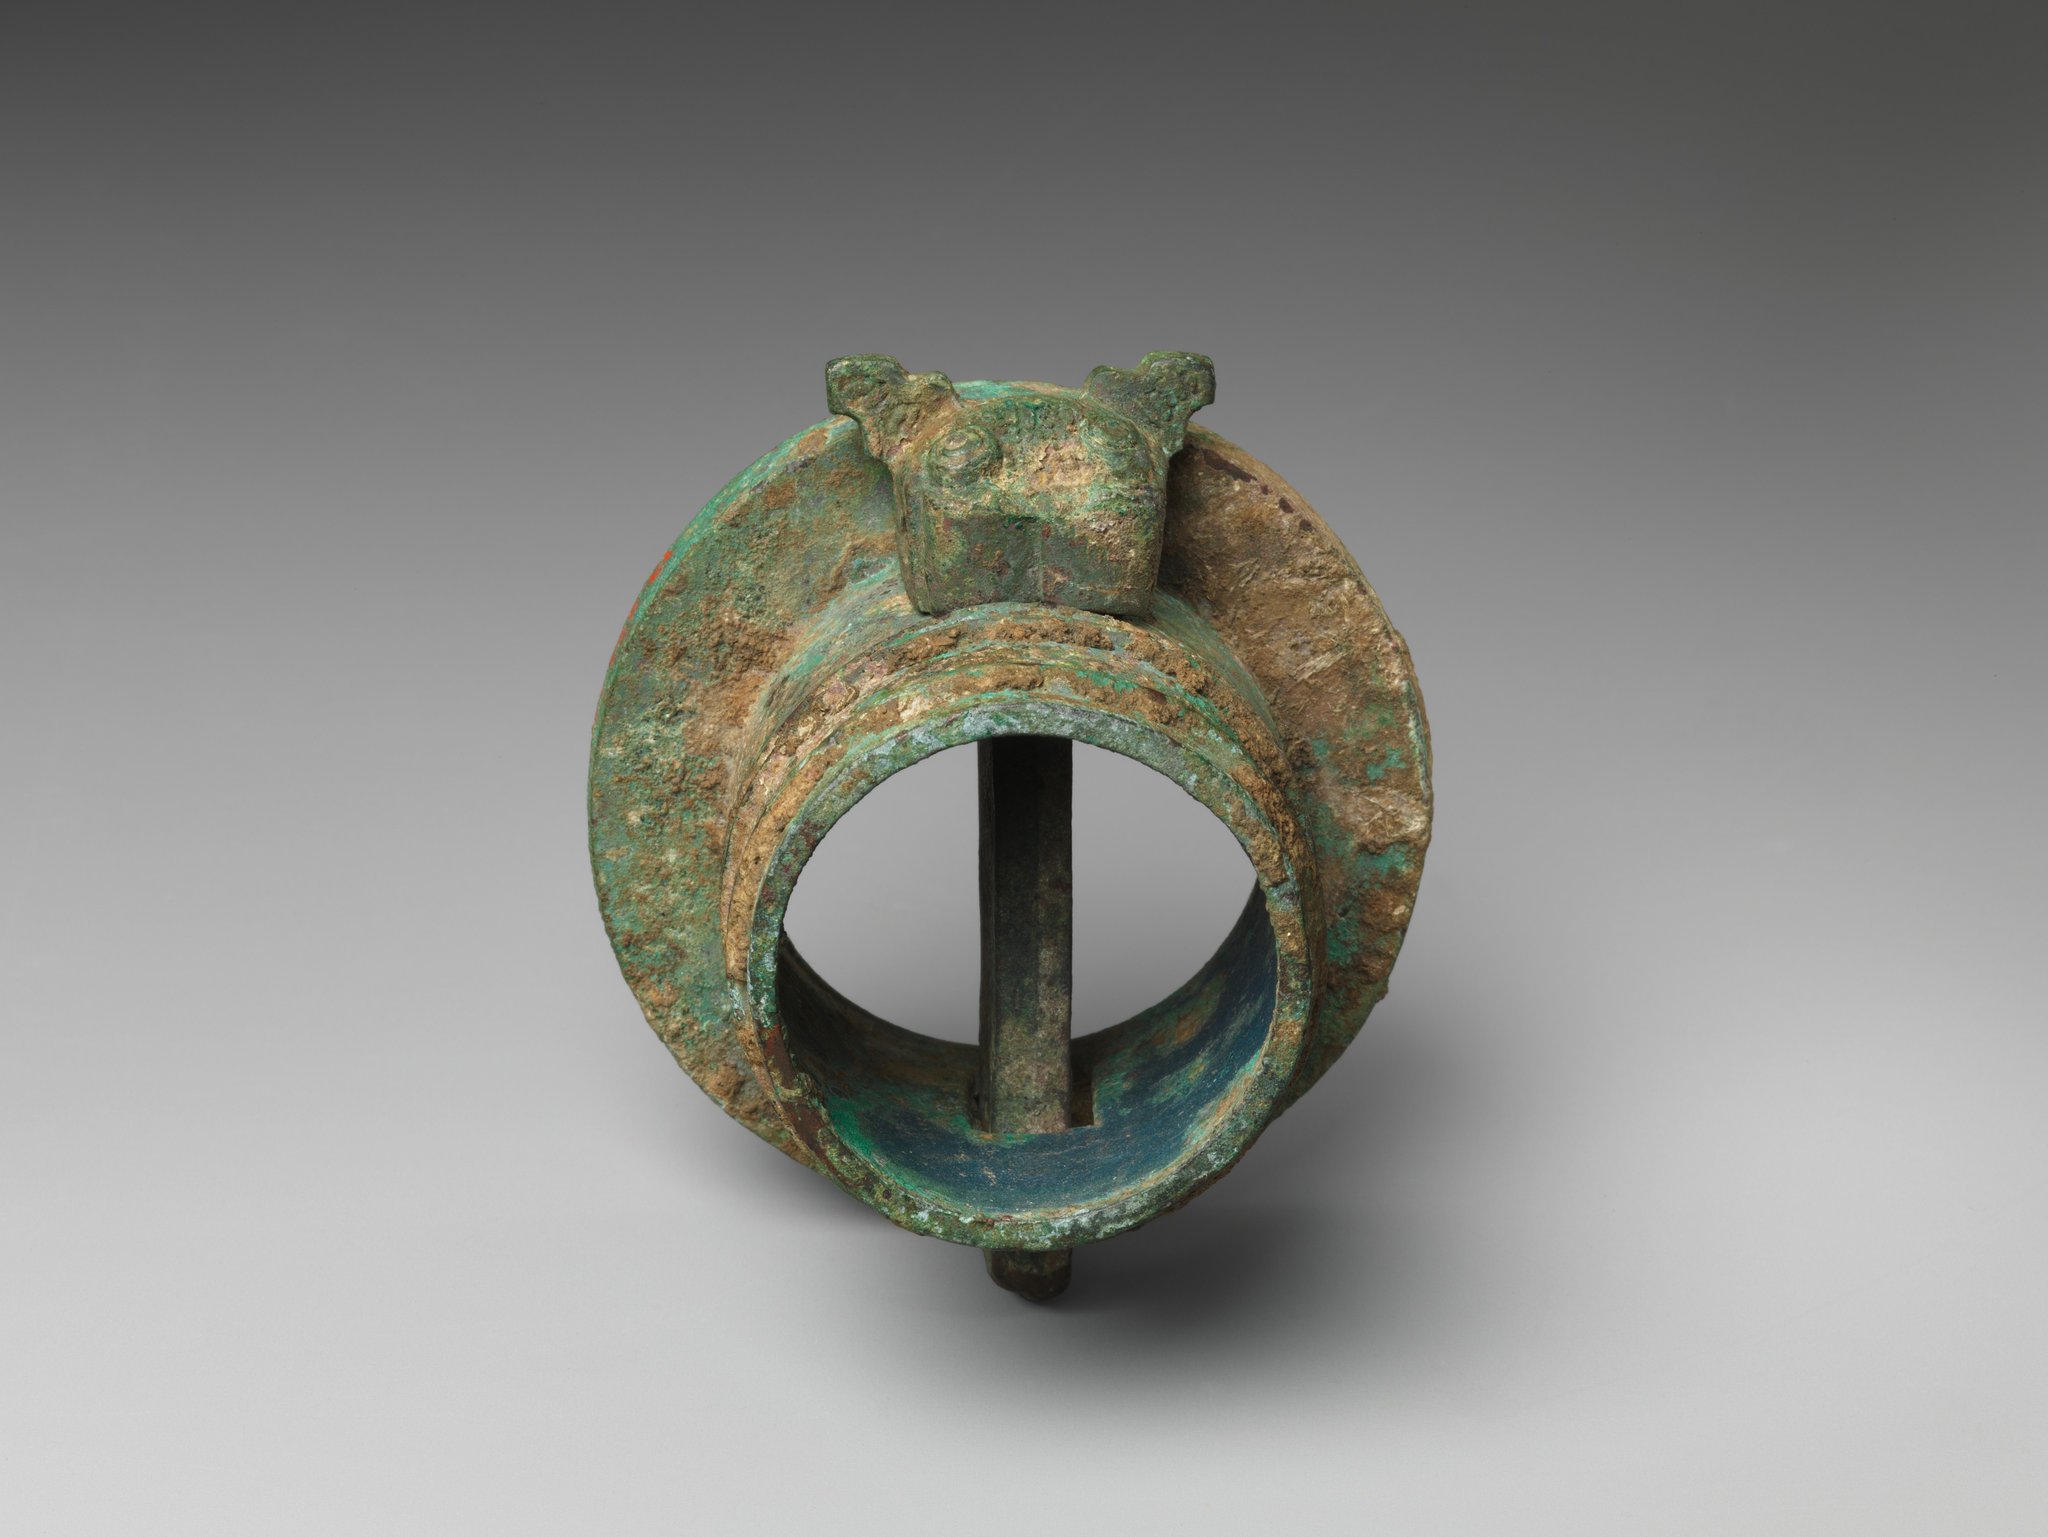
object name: chariot fitting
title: Chariot axle cap and linchpin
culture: chinese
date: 600-401 BCE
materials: bronze